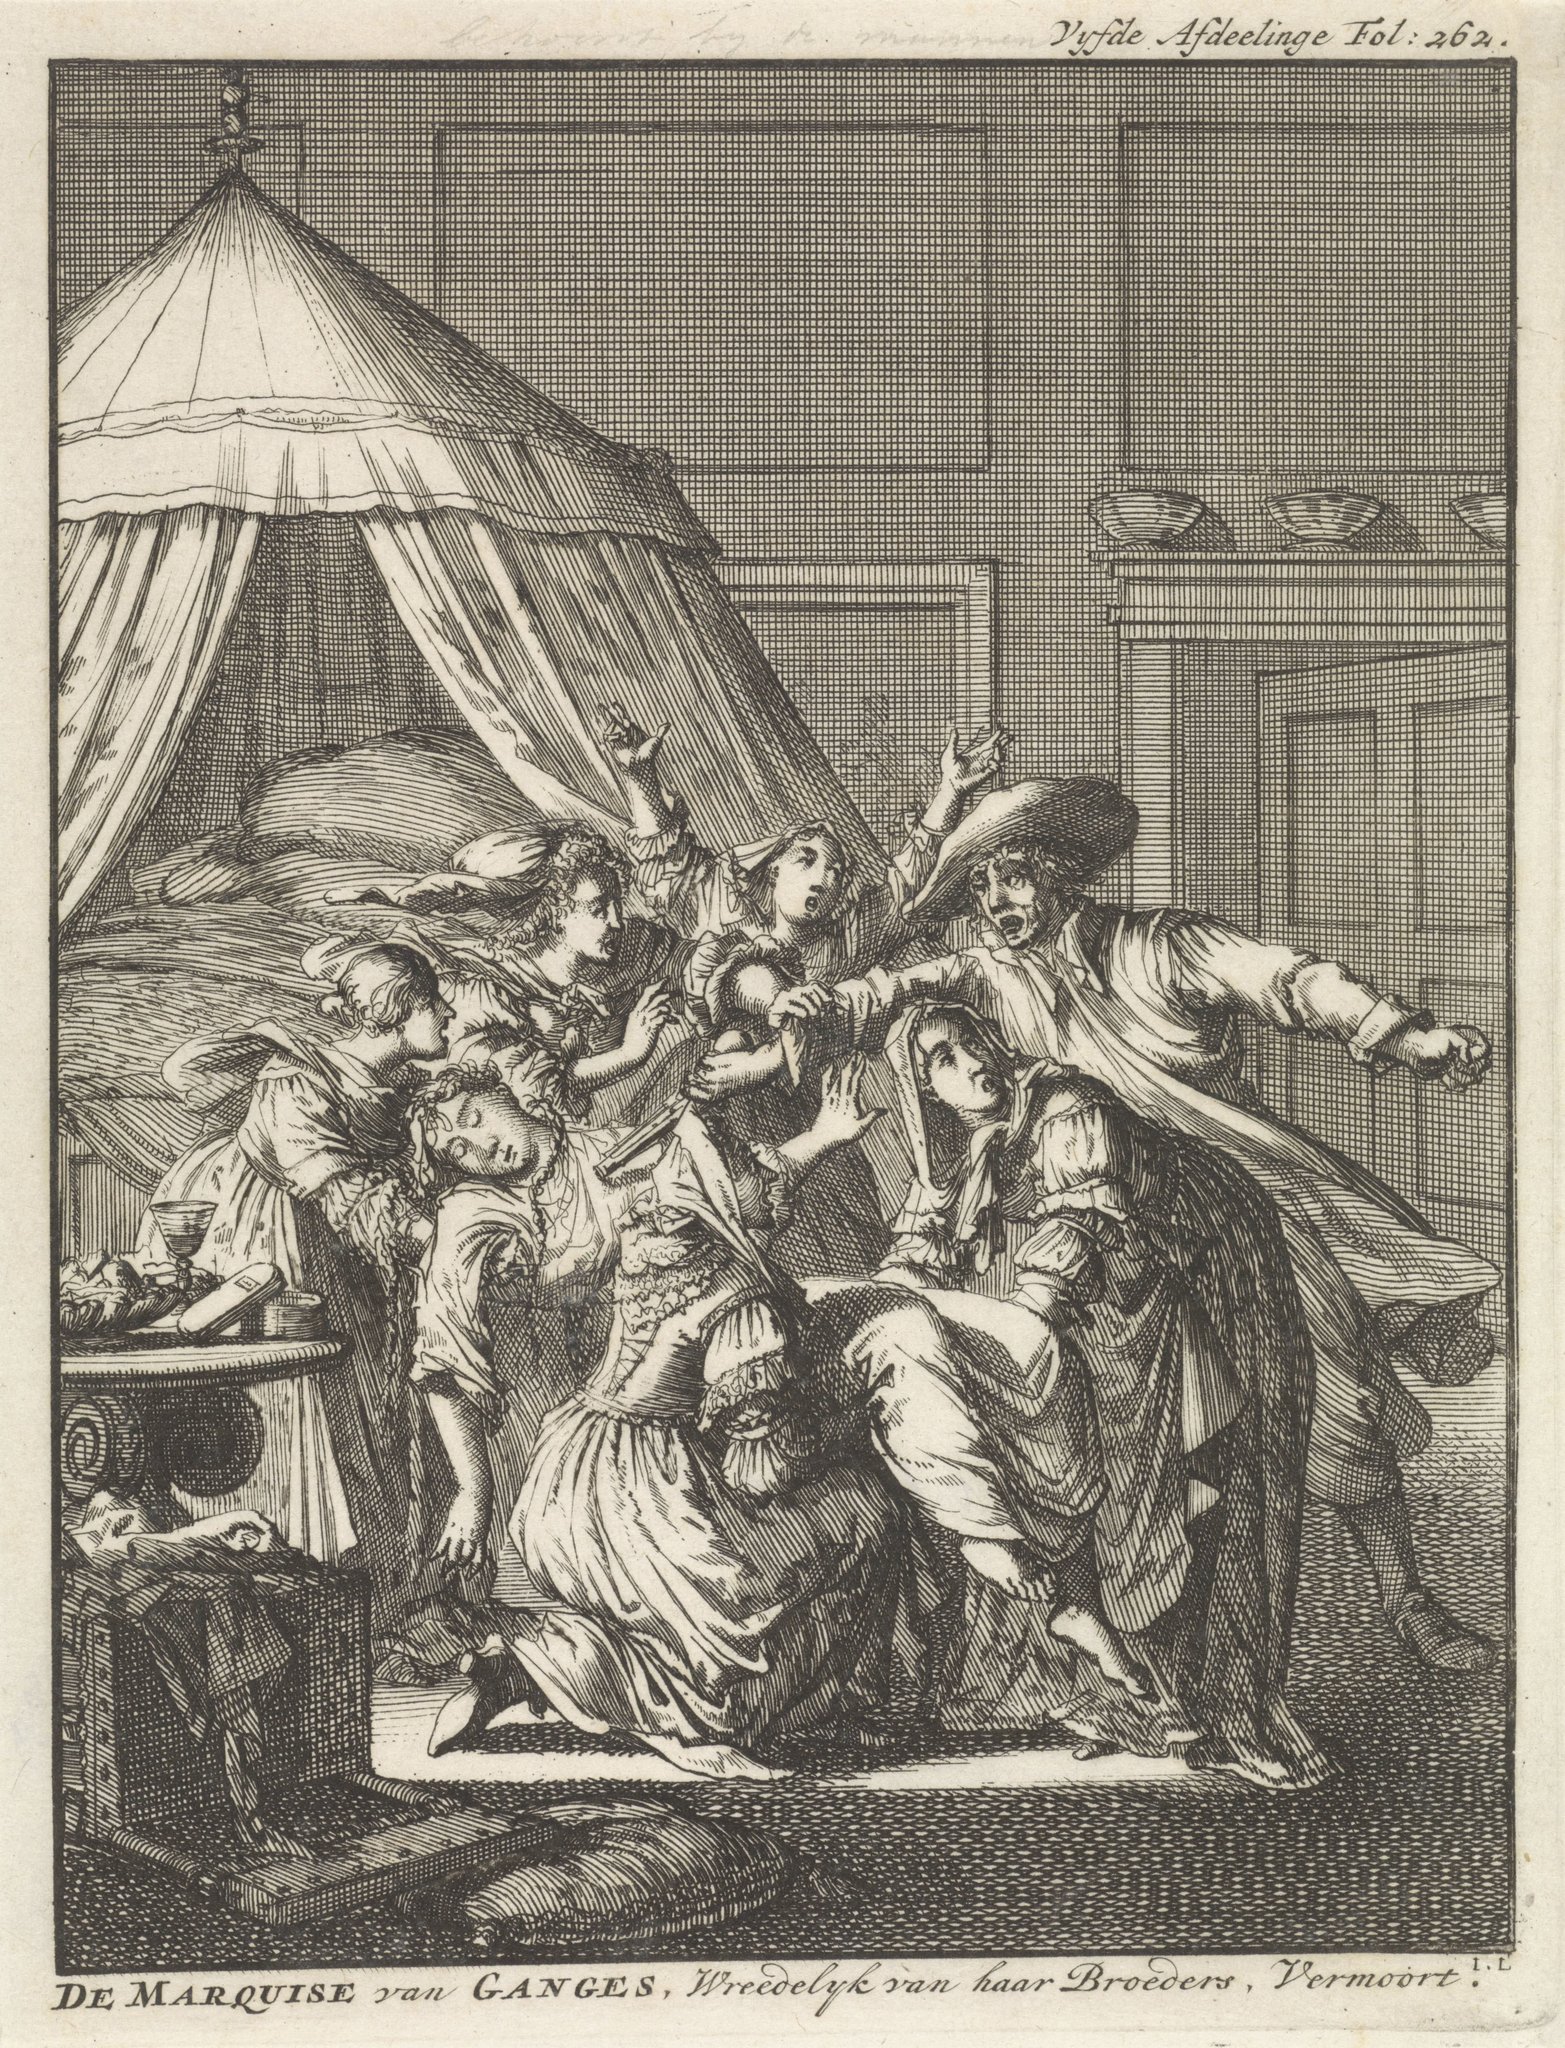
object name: book illustration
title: De Marquise van Ganges, Wreedelyk van haar Broeders, Vermoort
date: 1698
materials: paper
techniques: etching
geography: amsterdam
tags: murder, violent death by firearms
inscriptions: collector's mark: Lugt 2228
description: Illustratie uit: Bos, Lambert van den. Treur-toonneel der doorluchtige mannen, of Op- en ondergang der grooten, 3 delen. Amsterdam: Jan Claesz ten Hoorn, 1698, dl. III.